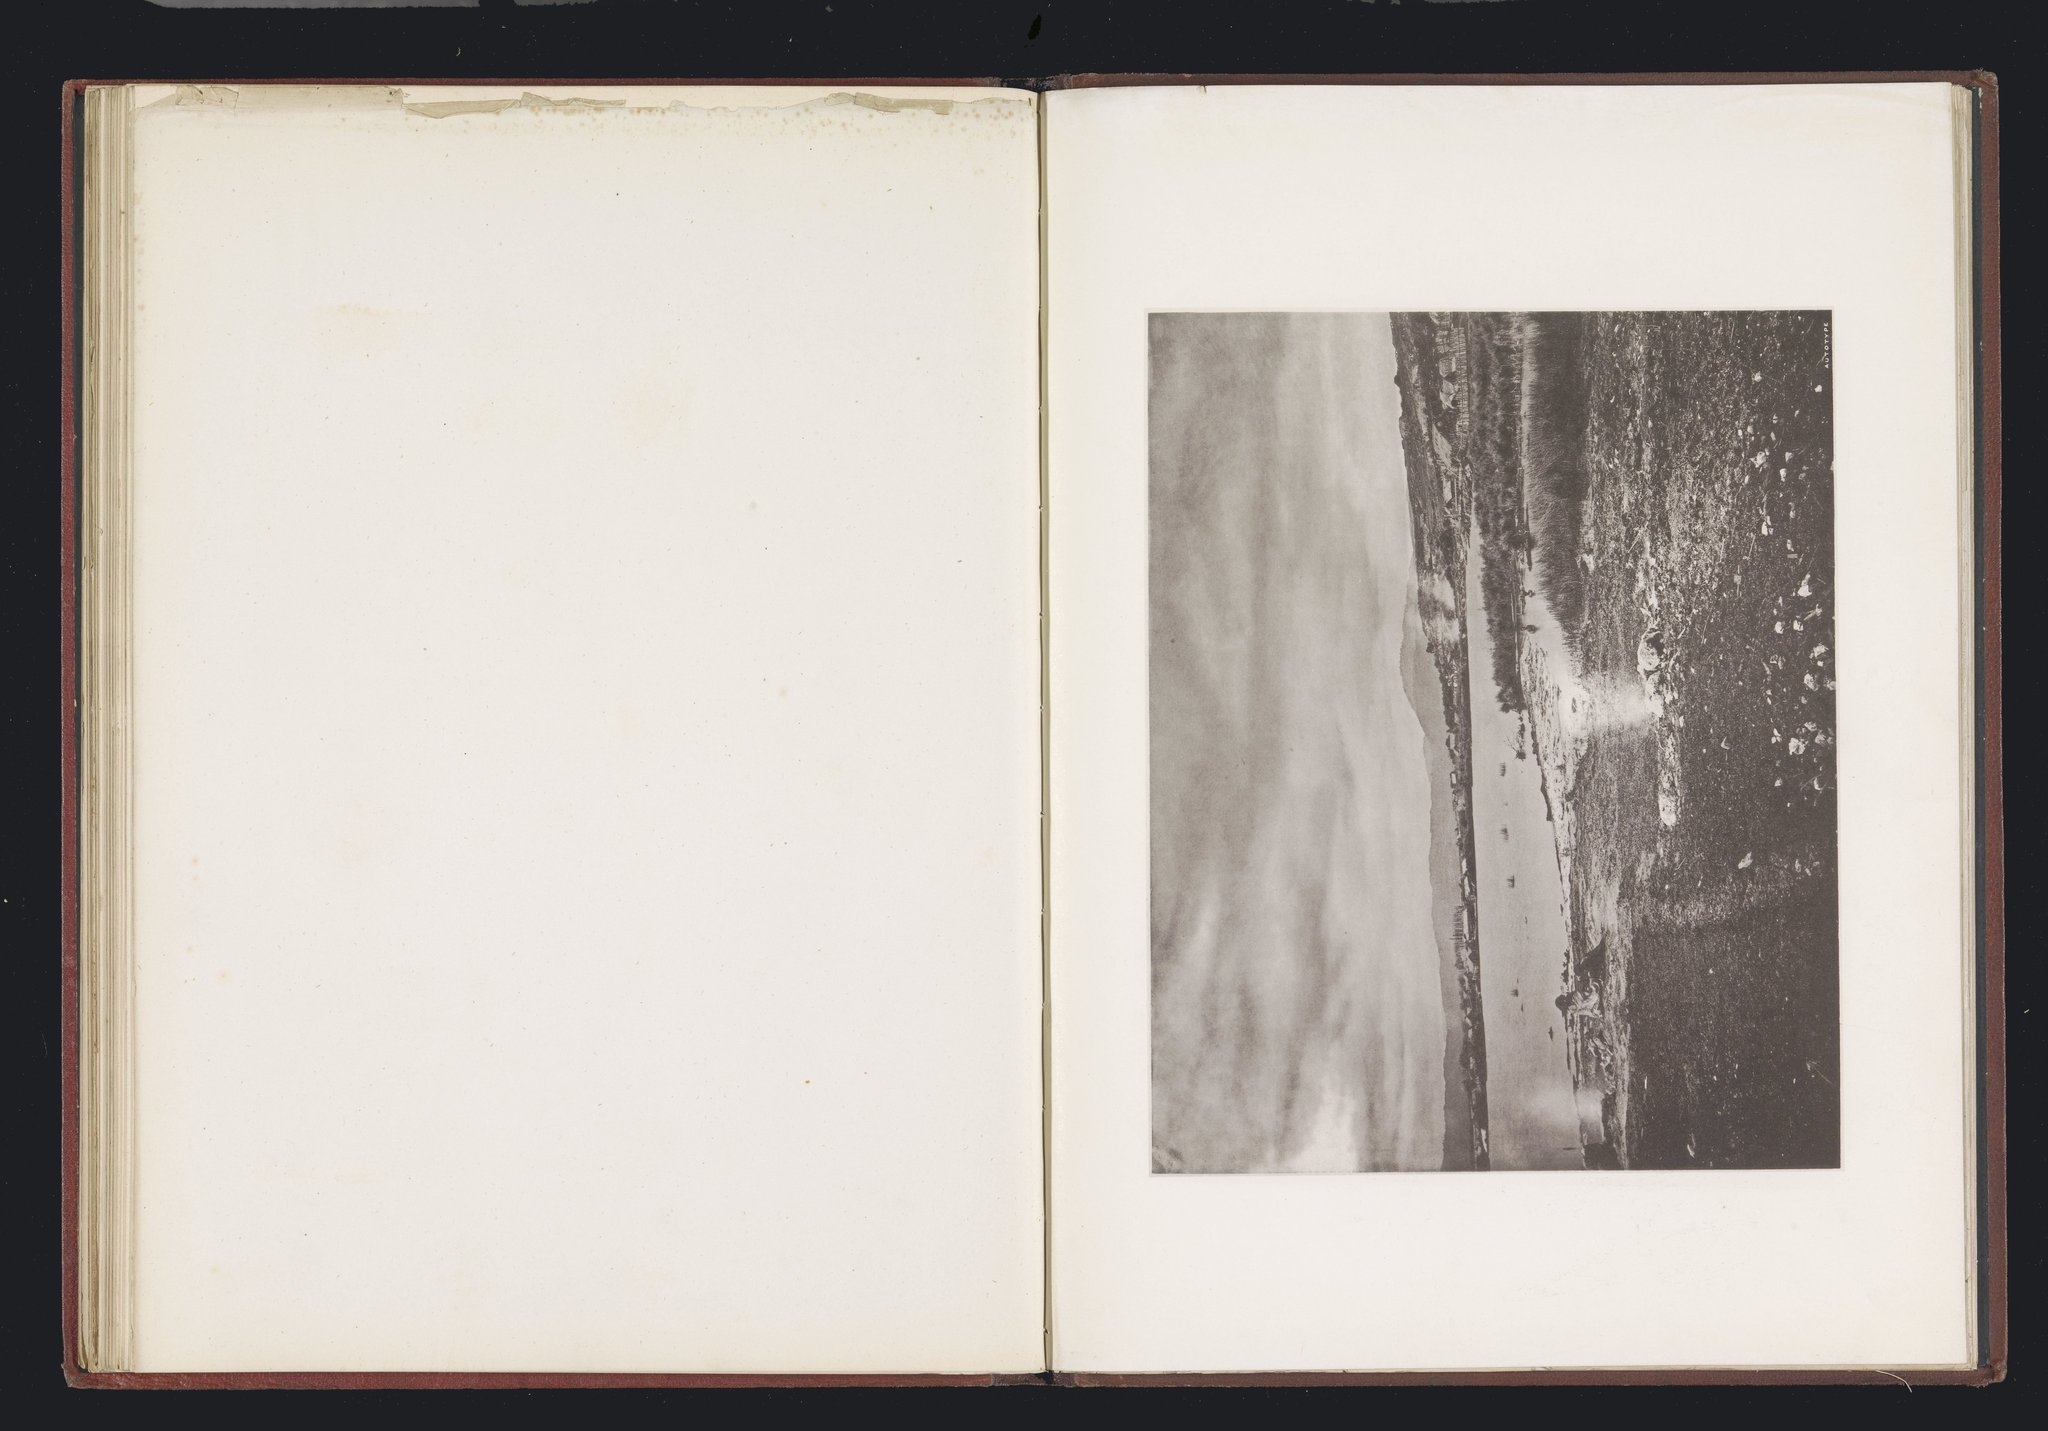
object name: photomechanical print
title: Gezicht op Lake Rotorua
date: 1865-1875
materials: paper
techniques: photograph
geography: united kingdom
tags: hot spring, geyser, lake